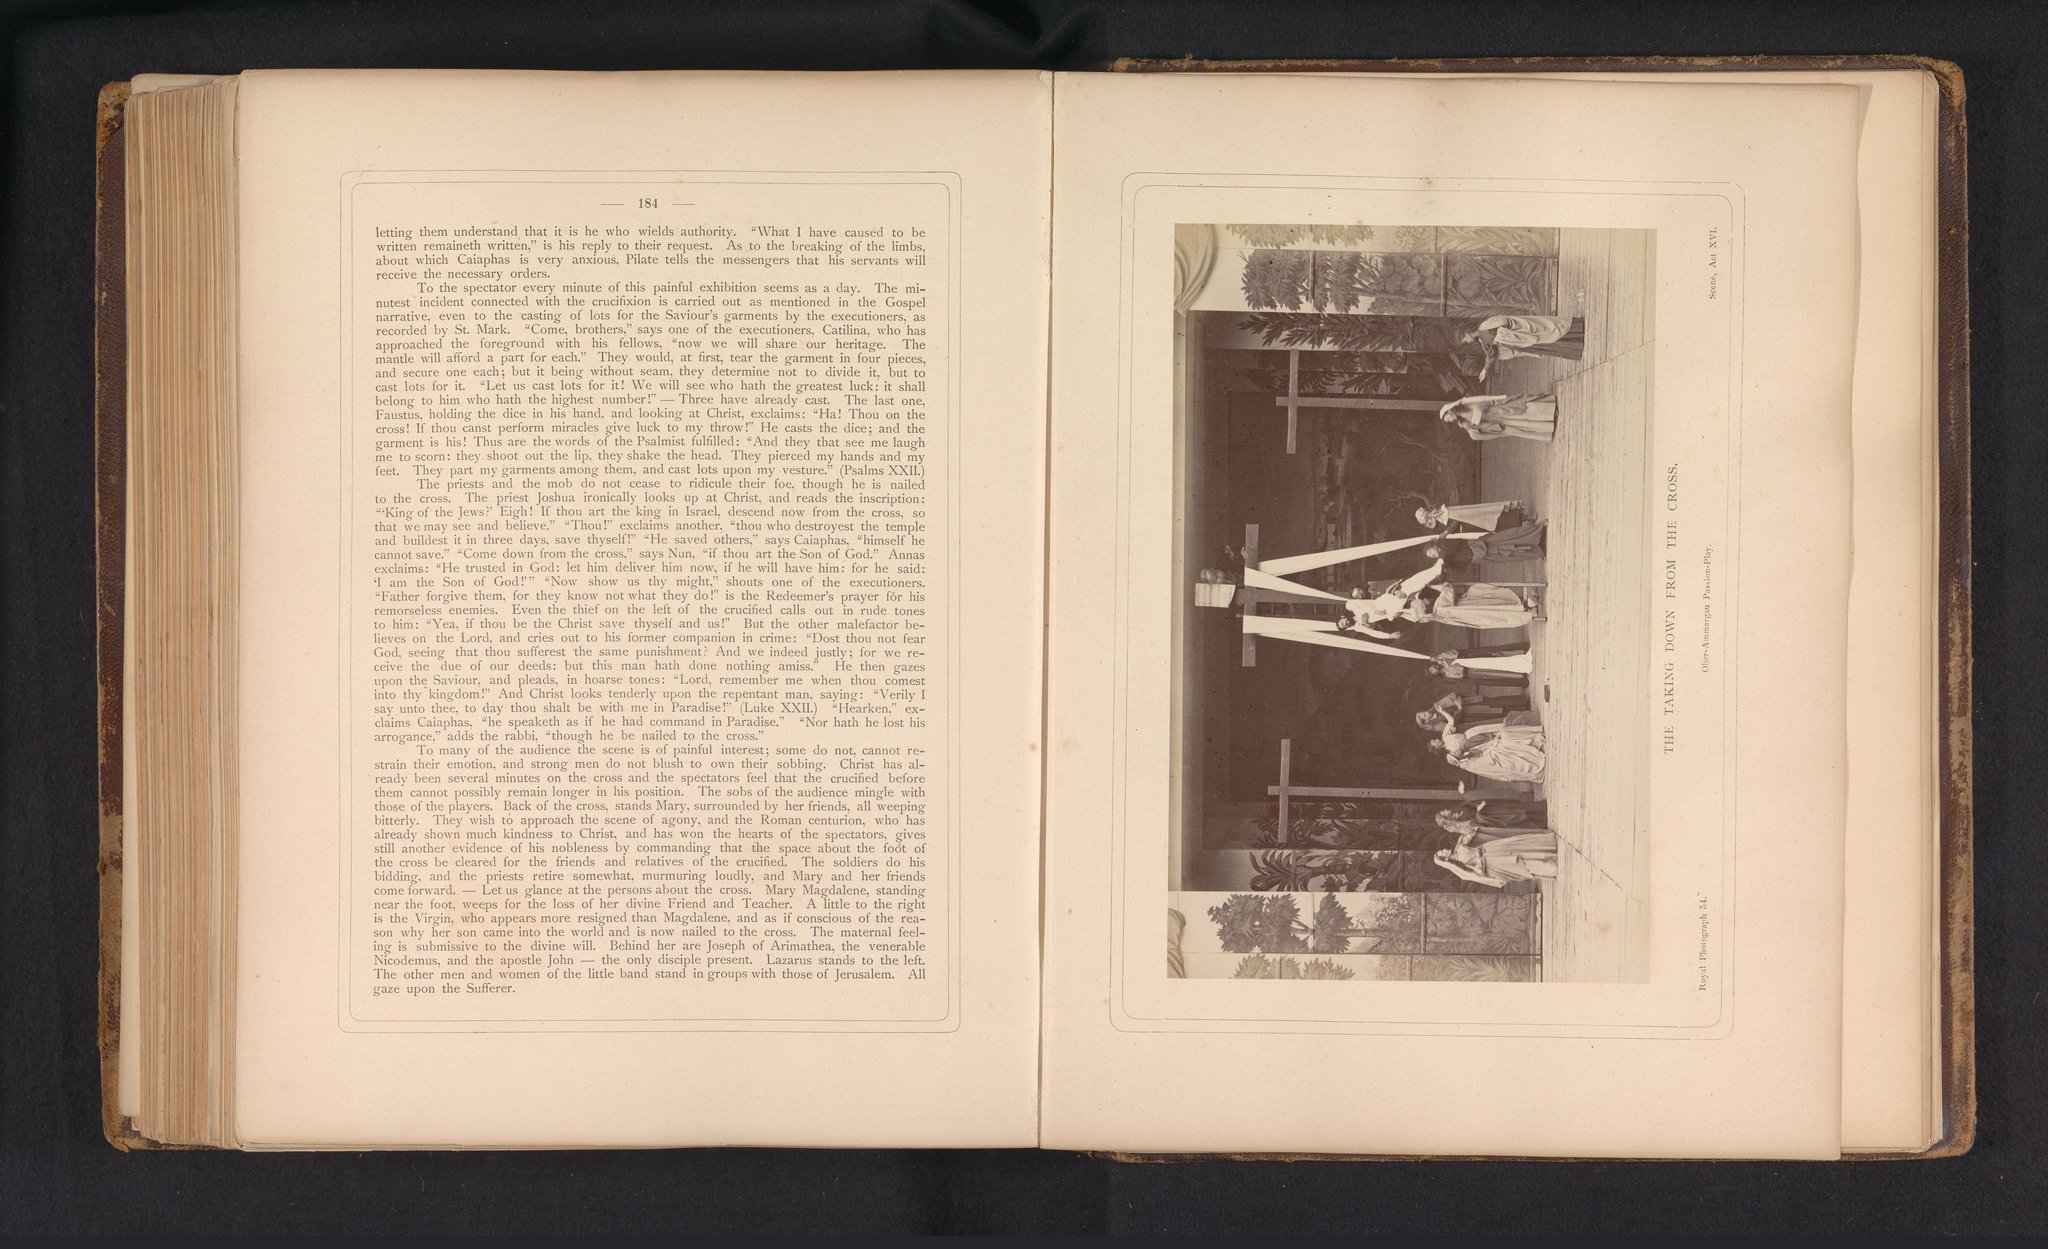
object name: page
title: The taking down from the cross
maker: joseph albert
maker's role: printer, publisher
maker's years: 1825-1886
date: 1868-1873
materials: photographic support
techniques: albumen print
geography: oberammergau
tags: descent from the cross: christ is taken down from the cross, usually by nicodemus and joseph of arimathaea who are standing on the ladders (both arms of christ detached), group of actors, troupe; actors on the stage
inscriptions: number: ‘Royal Photograph 54.’, number: ‘54.’